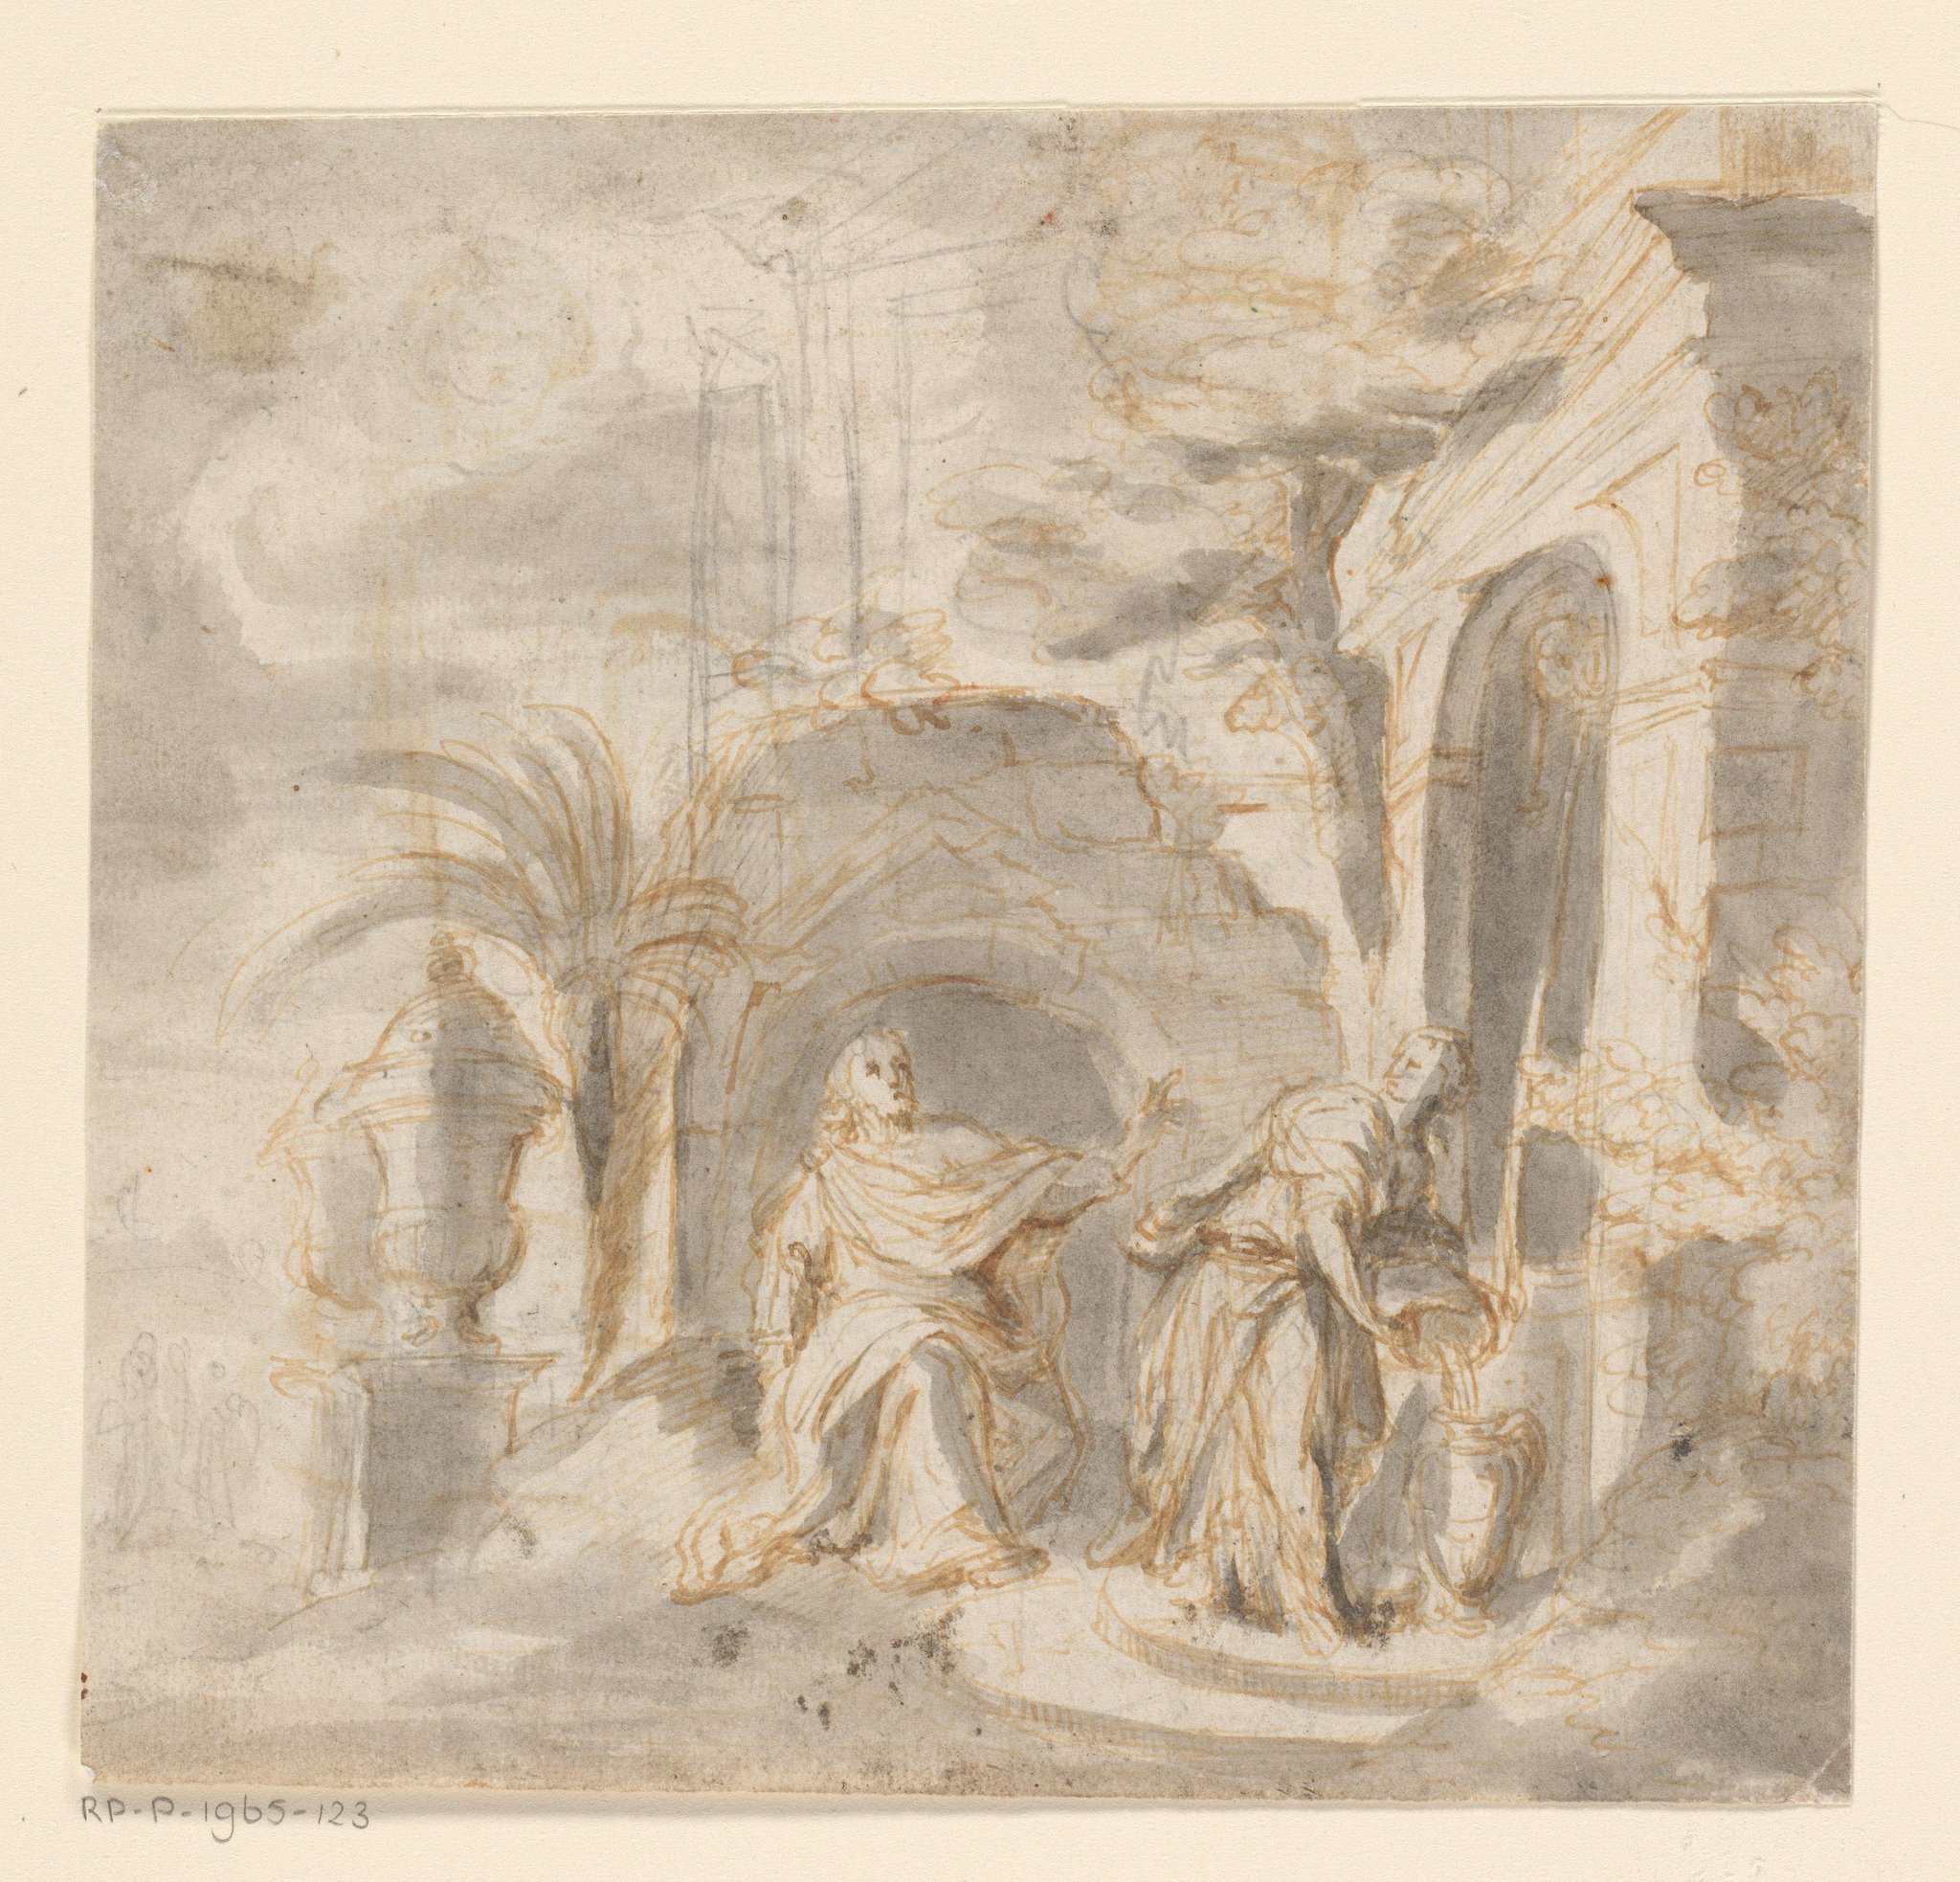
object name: ornamenttekening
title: Christus en de Samaritaanse vrouw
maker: Anonymous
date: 1675-1700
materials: ink, paper, pencil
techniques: brush, pen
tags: christ and the woman of samaria: sitting at jacob's well he asks her for a drink from her jug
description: In een landschap voor een boog zit Christus. Rechts van hem staat de Samaritaanse vrouw met waterkruiken bij de Jakobsbron.